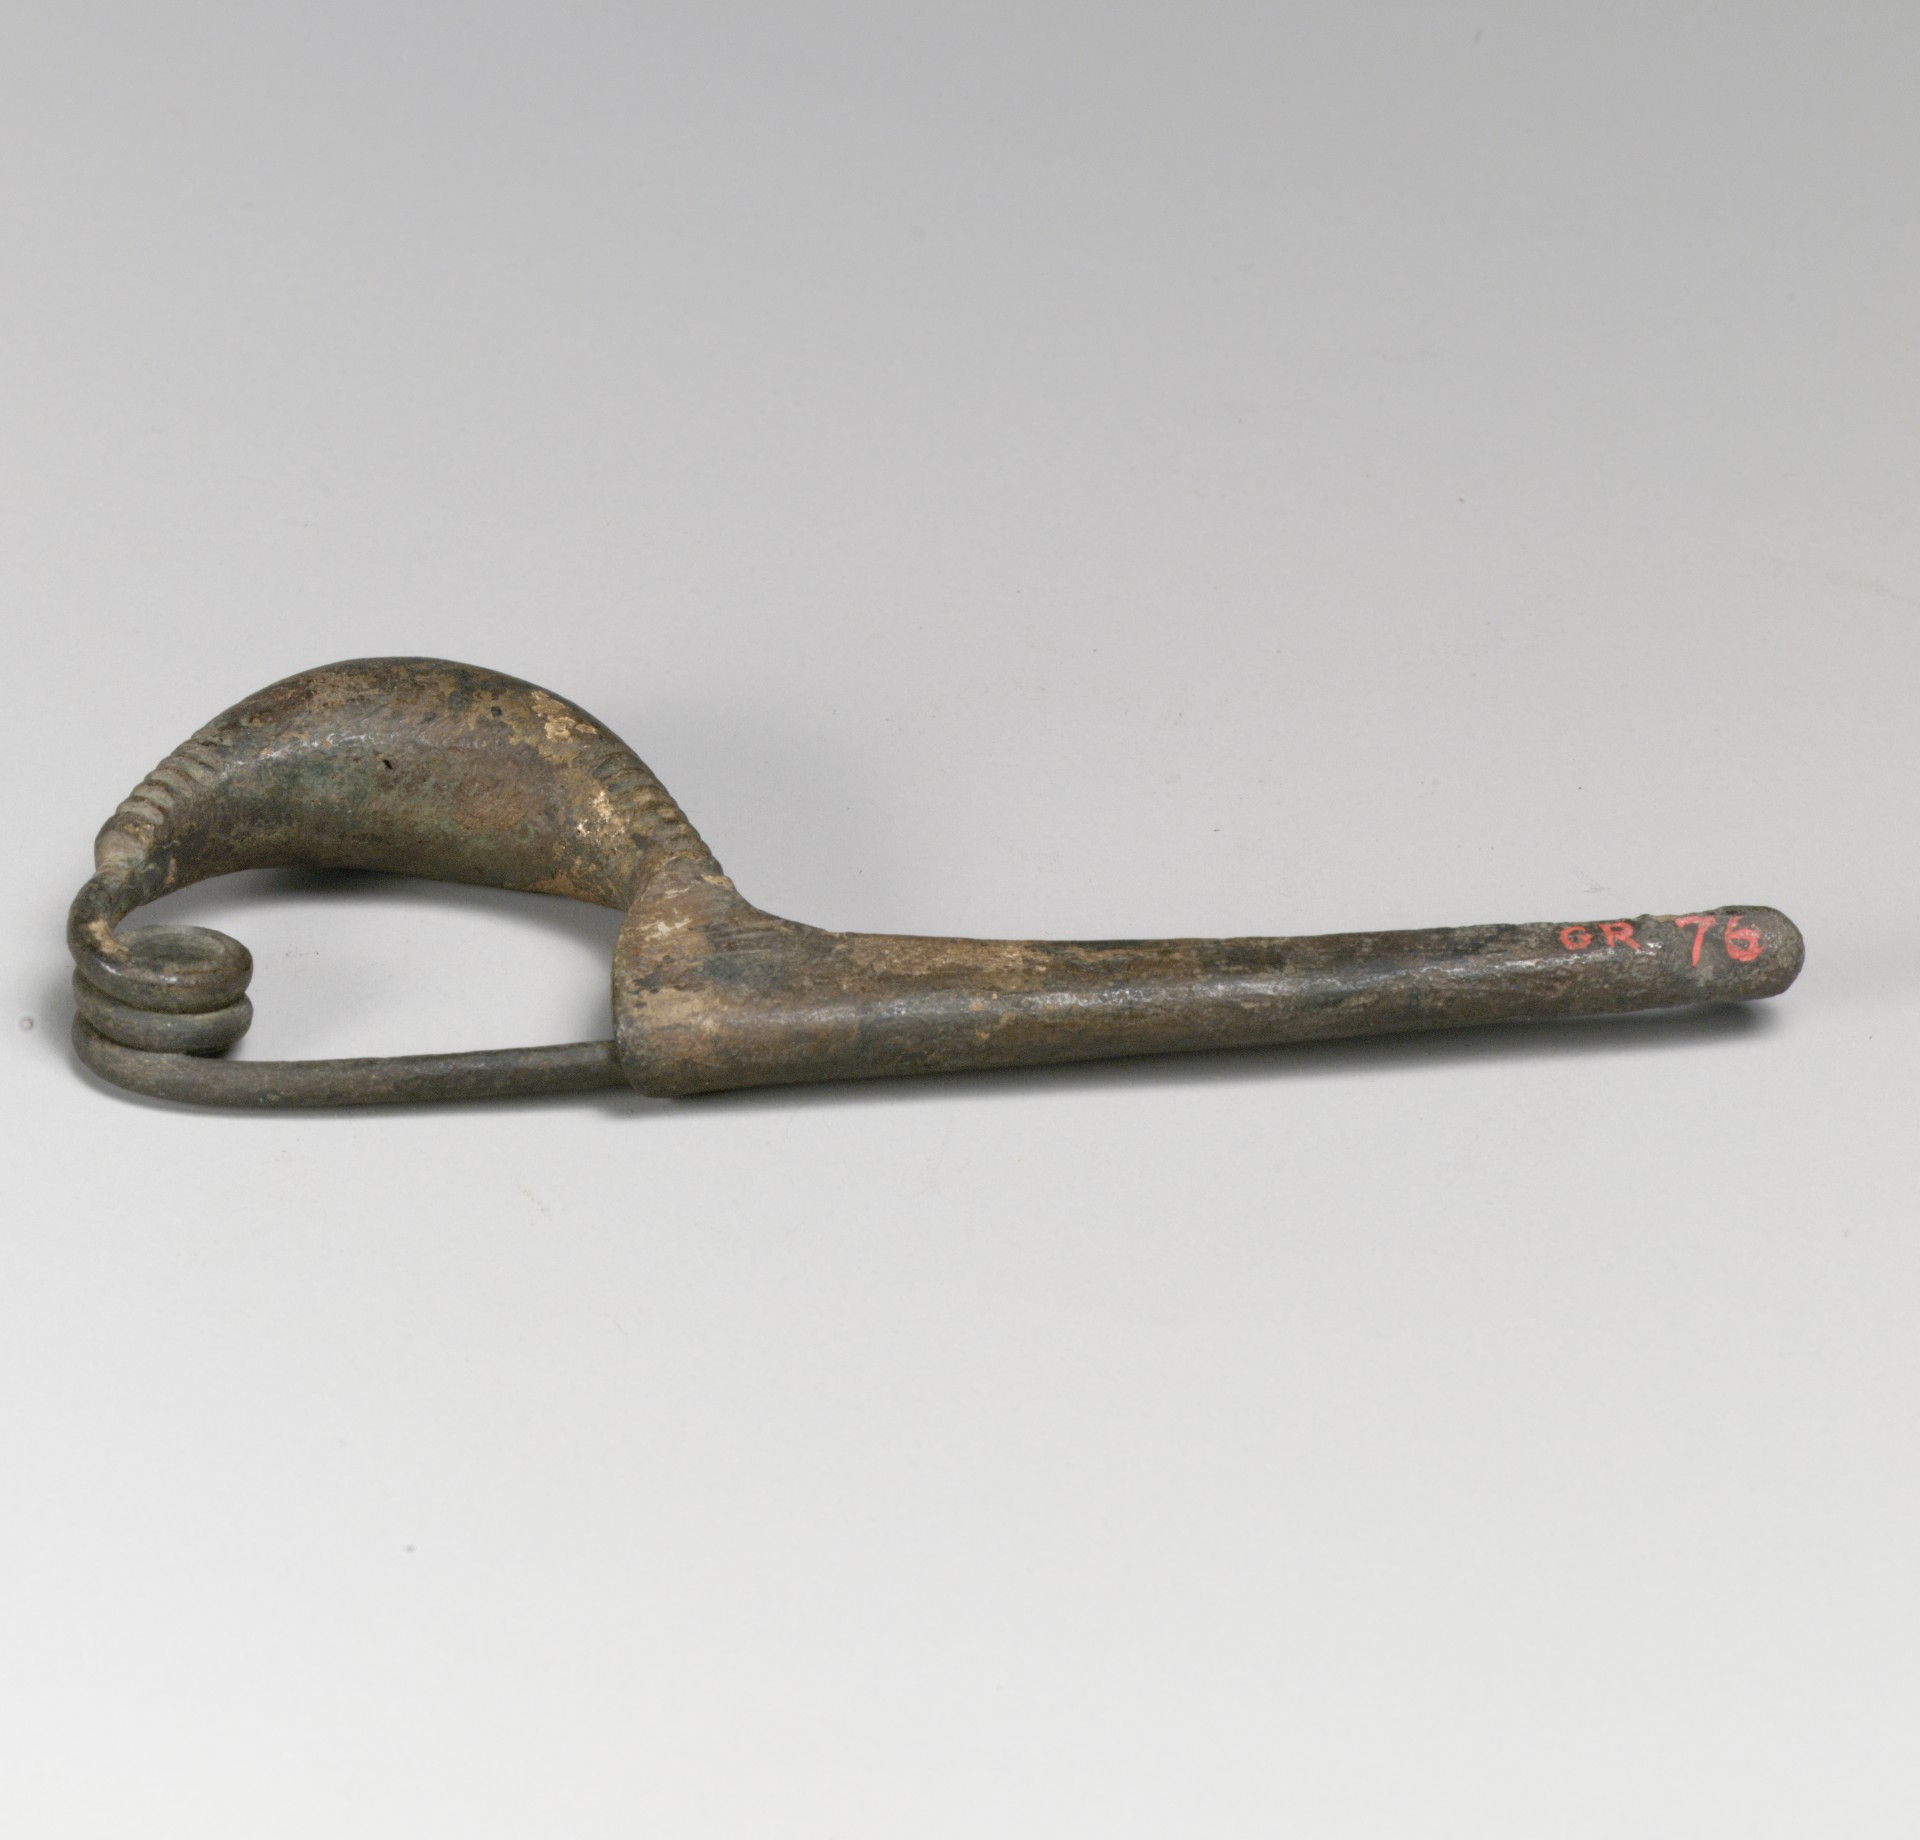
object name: fibula, boat shaped type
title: Fibula, boat-shaped type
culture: italic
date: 600-301 BCE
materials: bronze